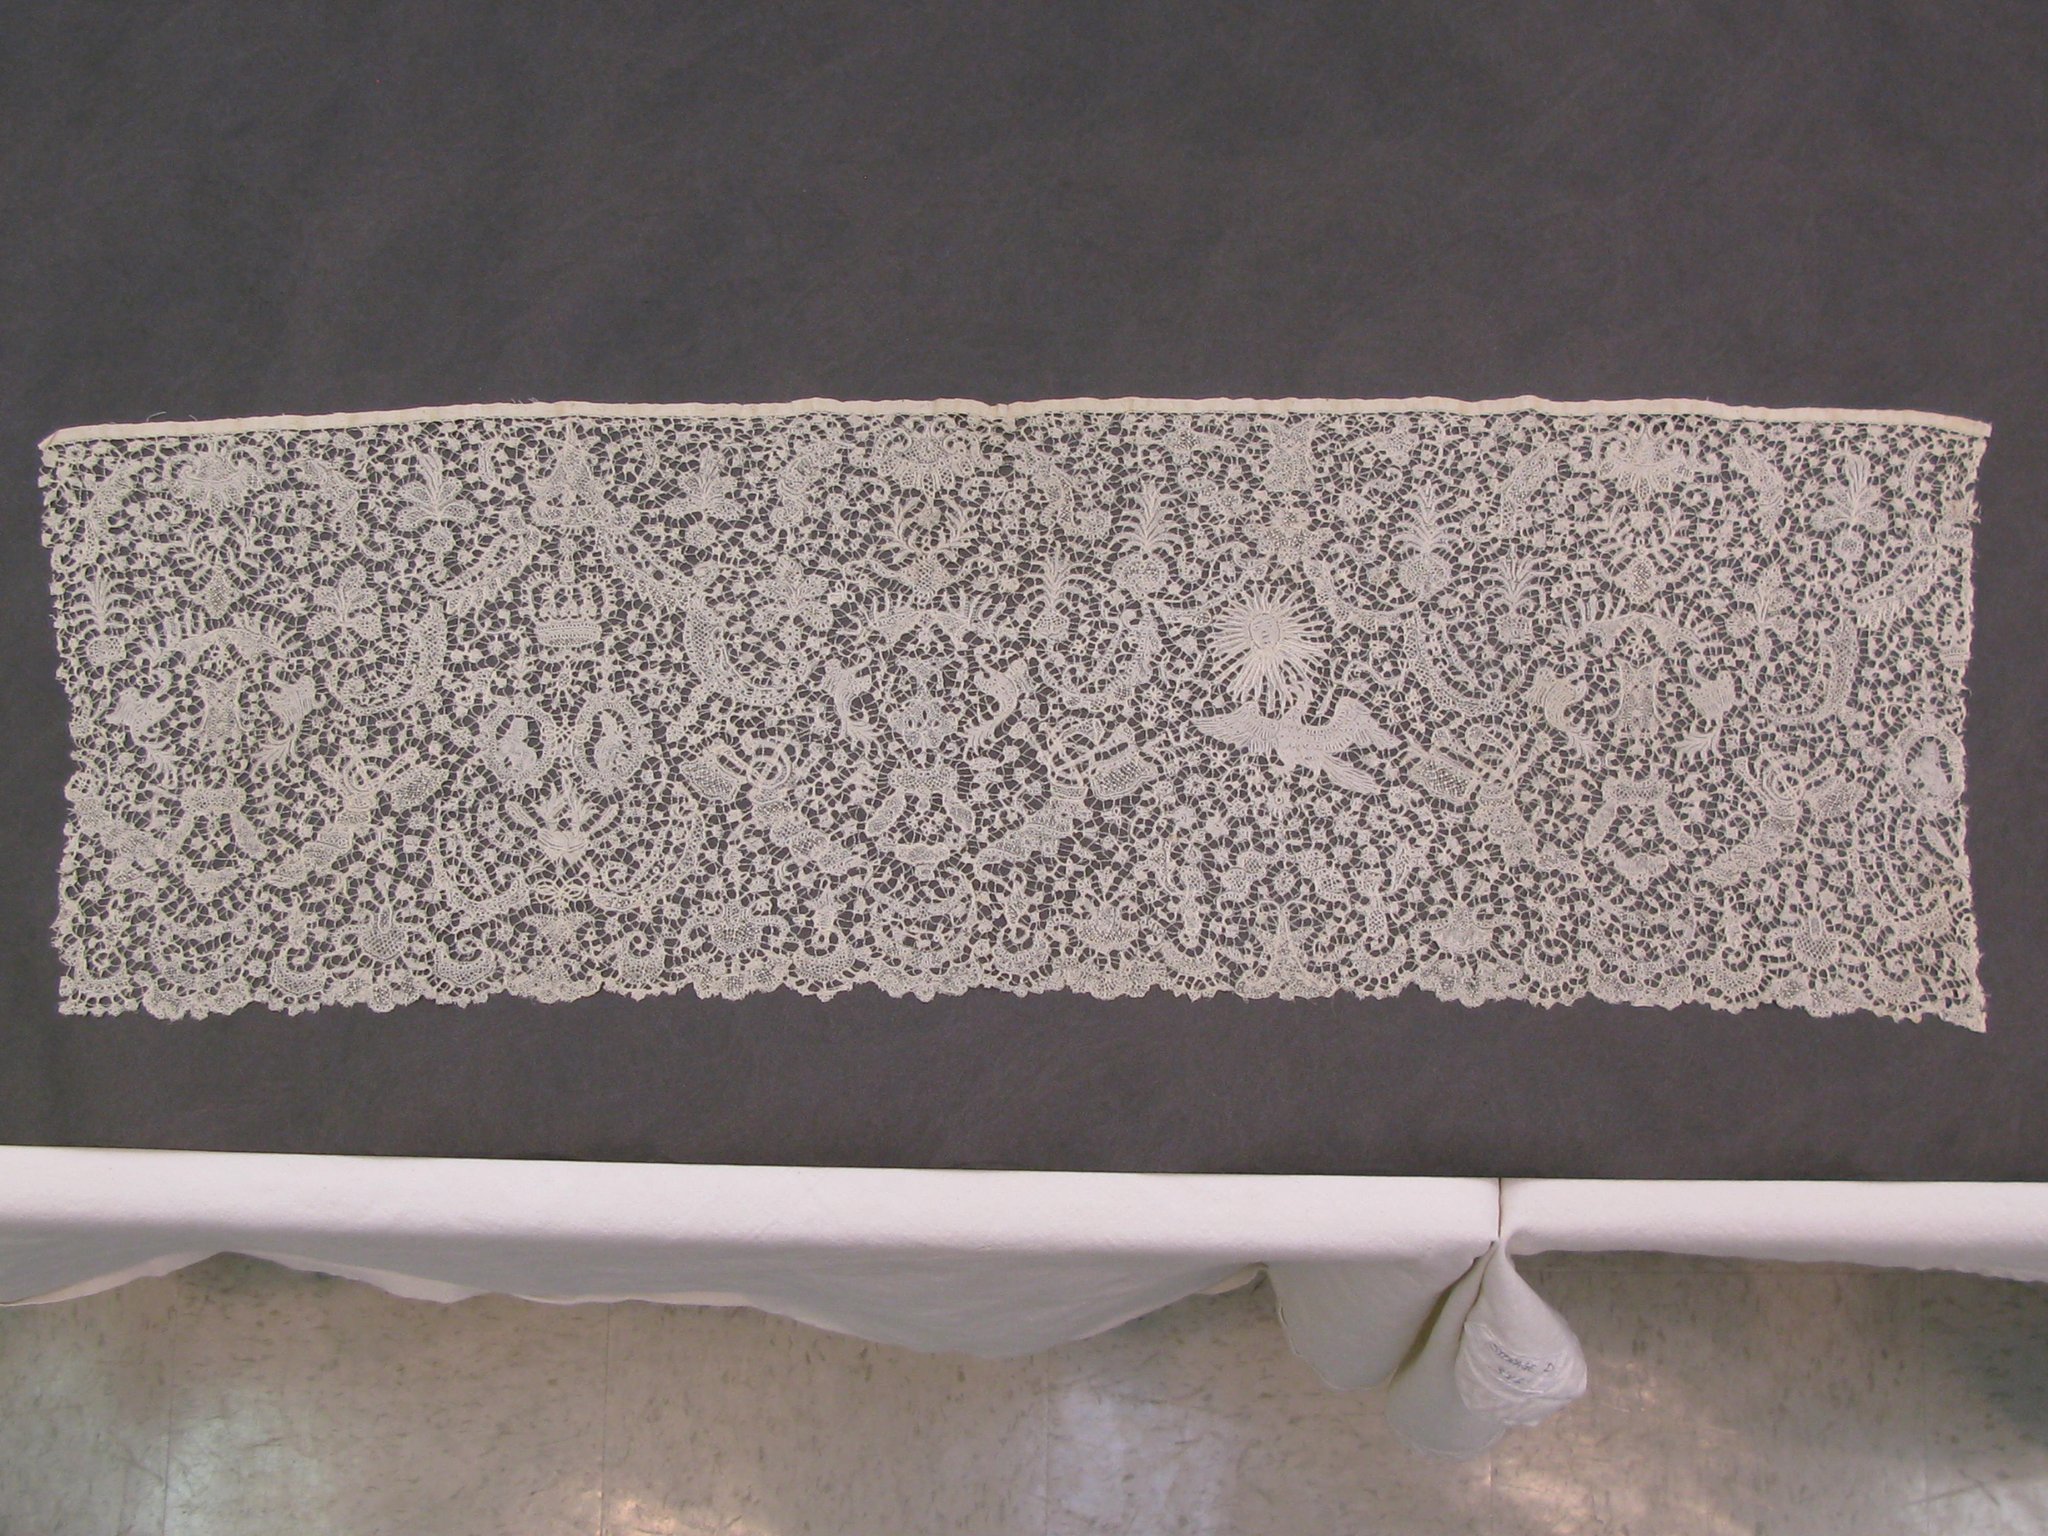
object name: flounce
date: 1695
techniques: lace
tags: birds